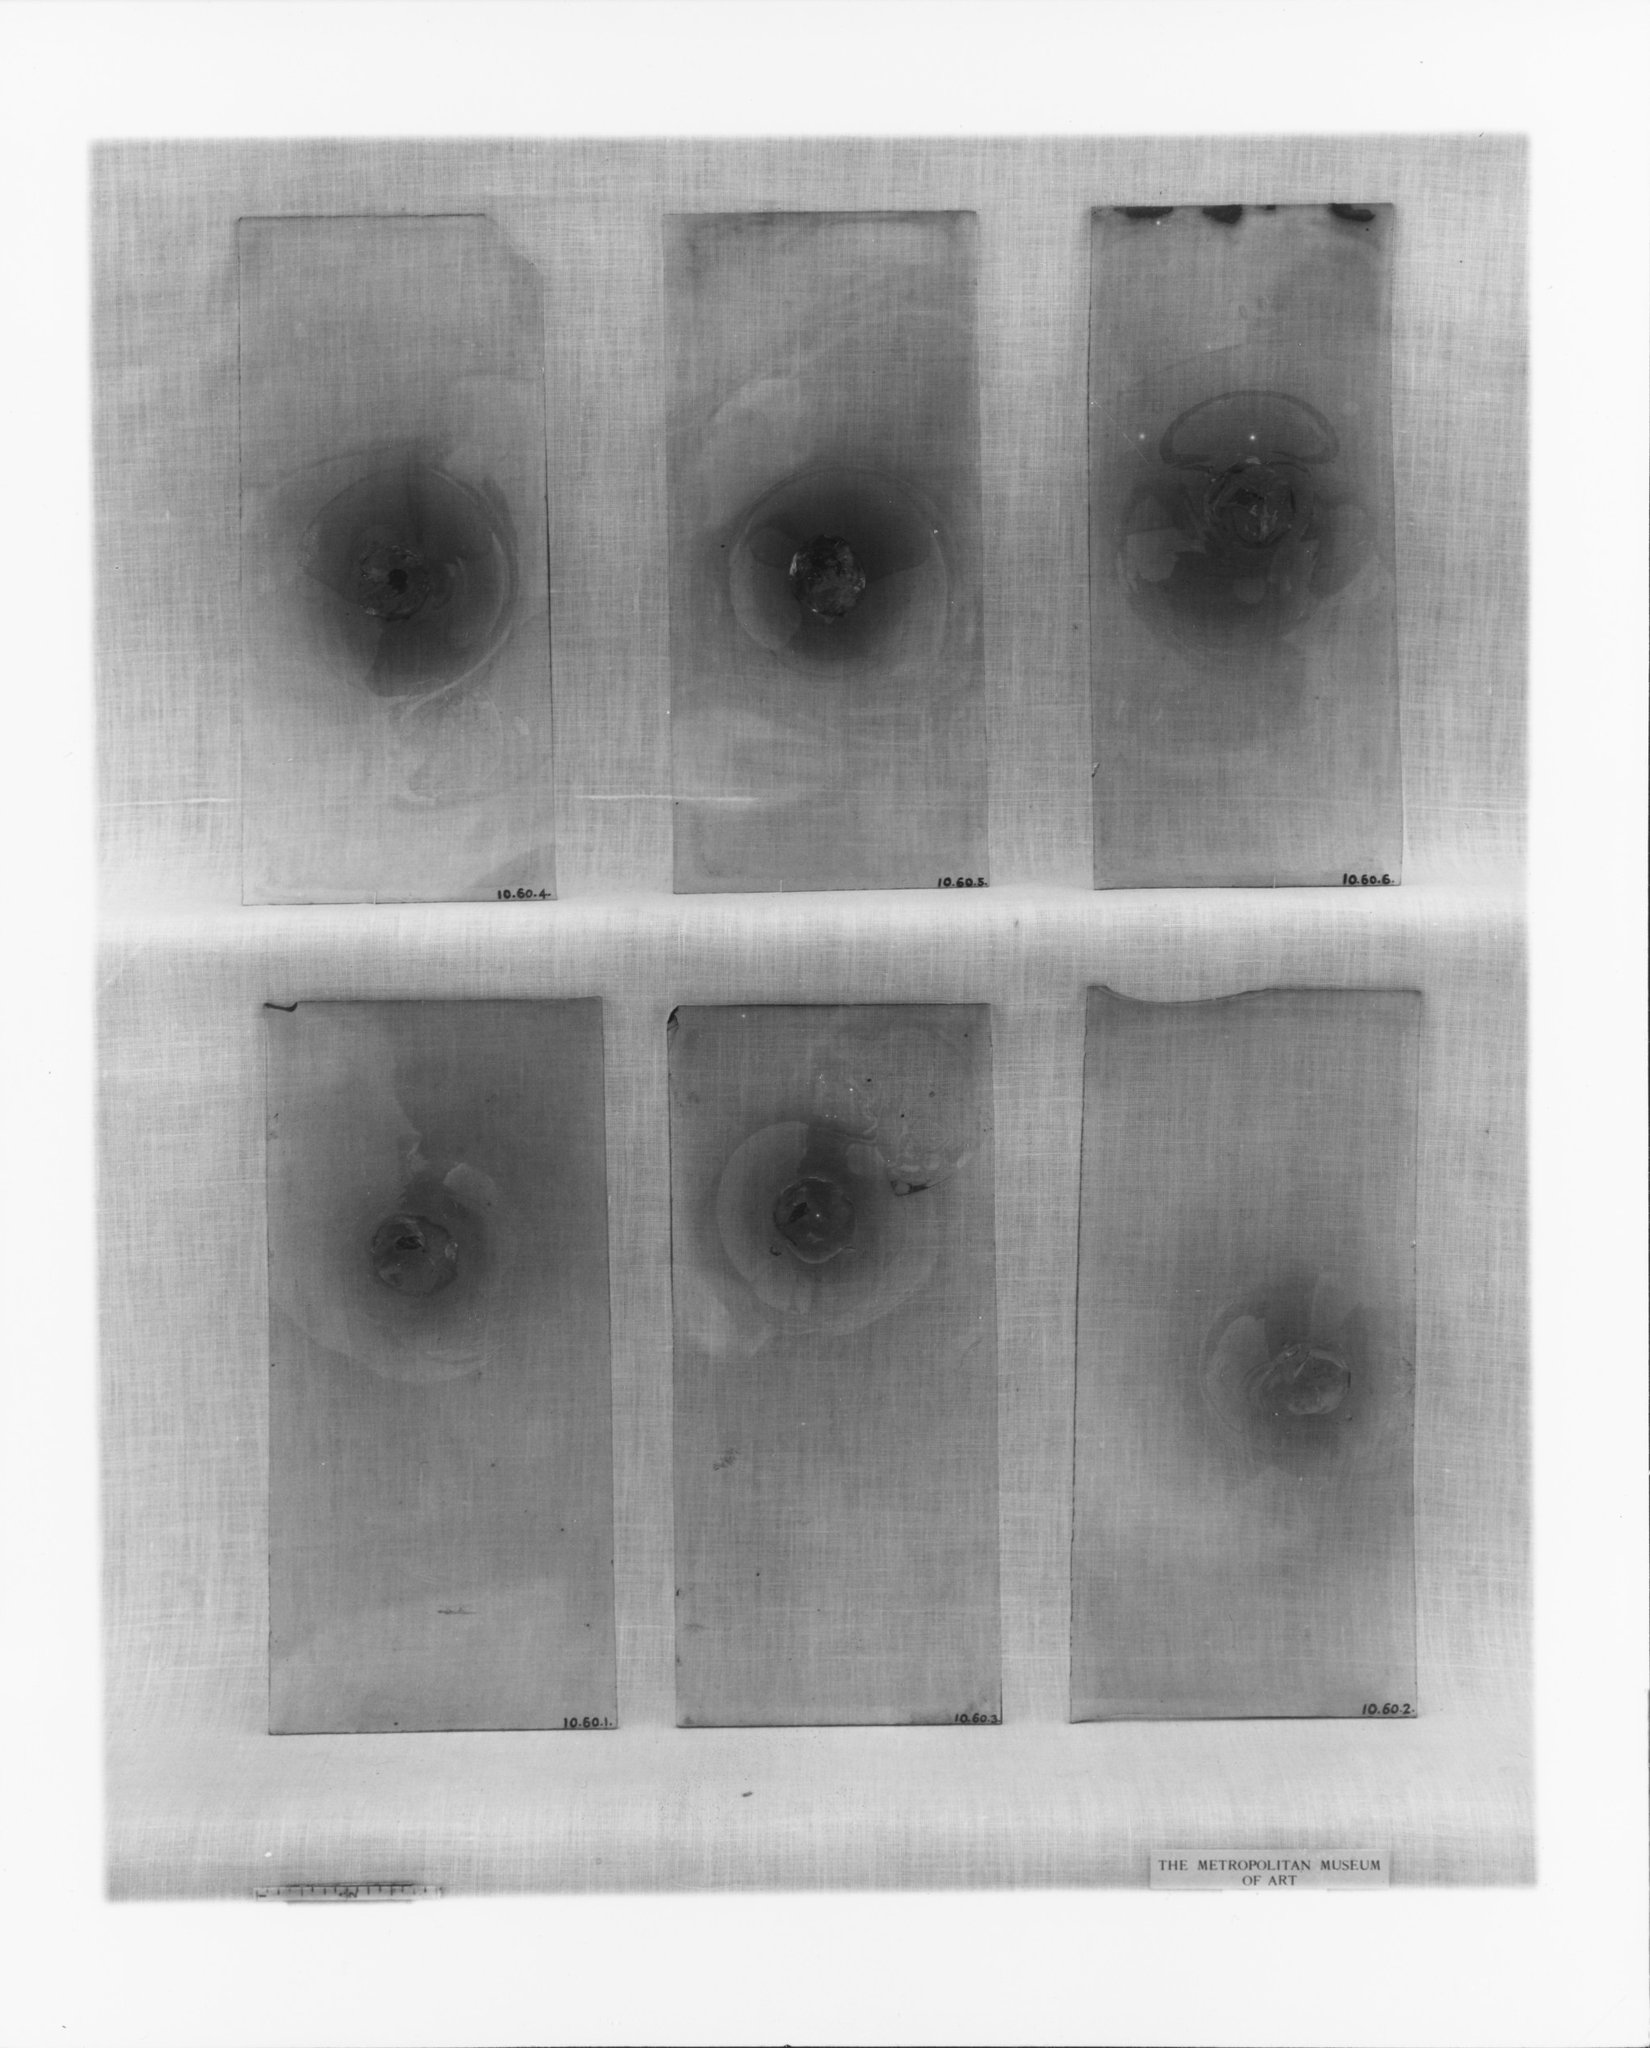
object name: windowpane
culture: american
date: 1701-1800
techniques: glassblowing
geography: united states